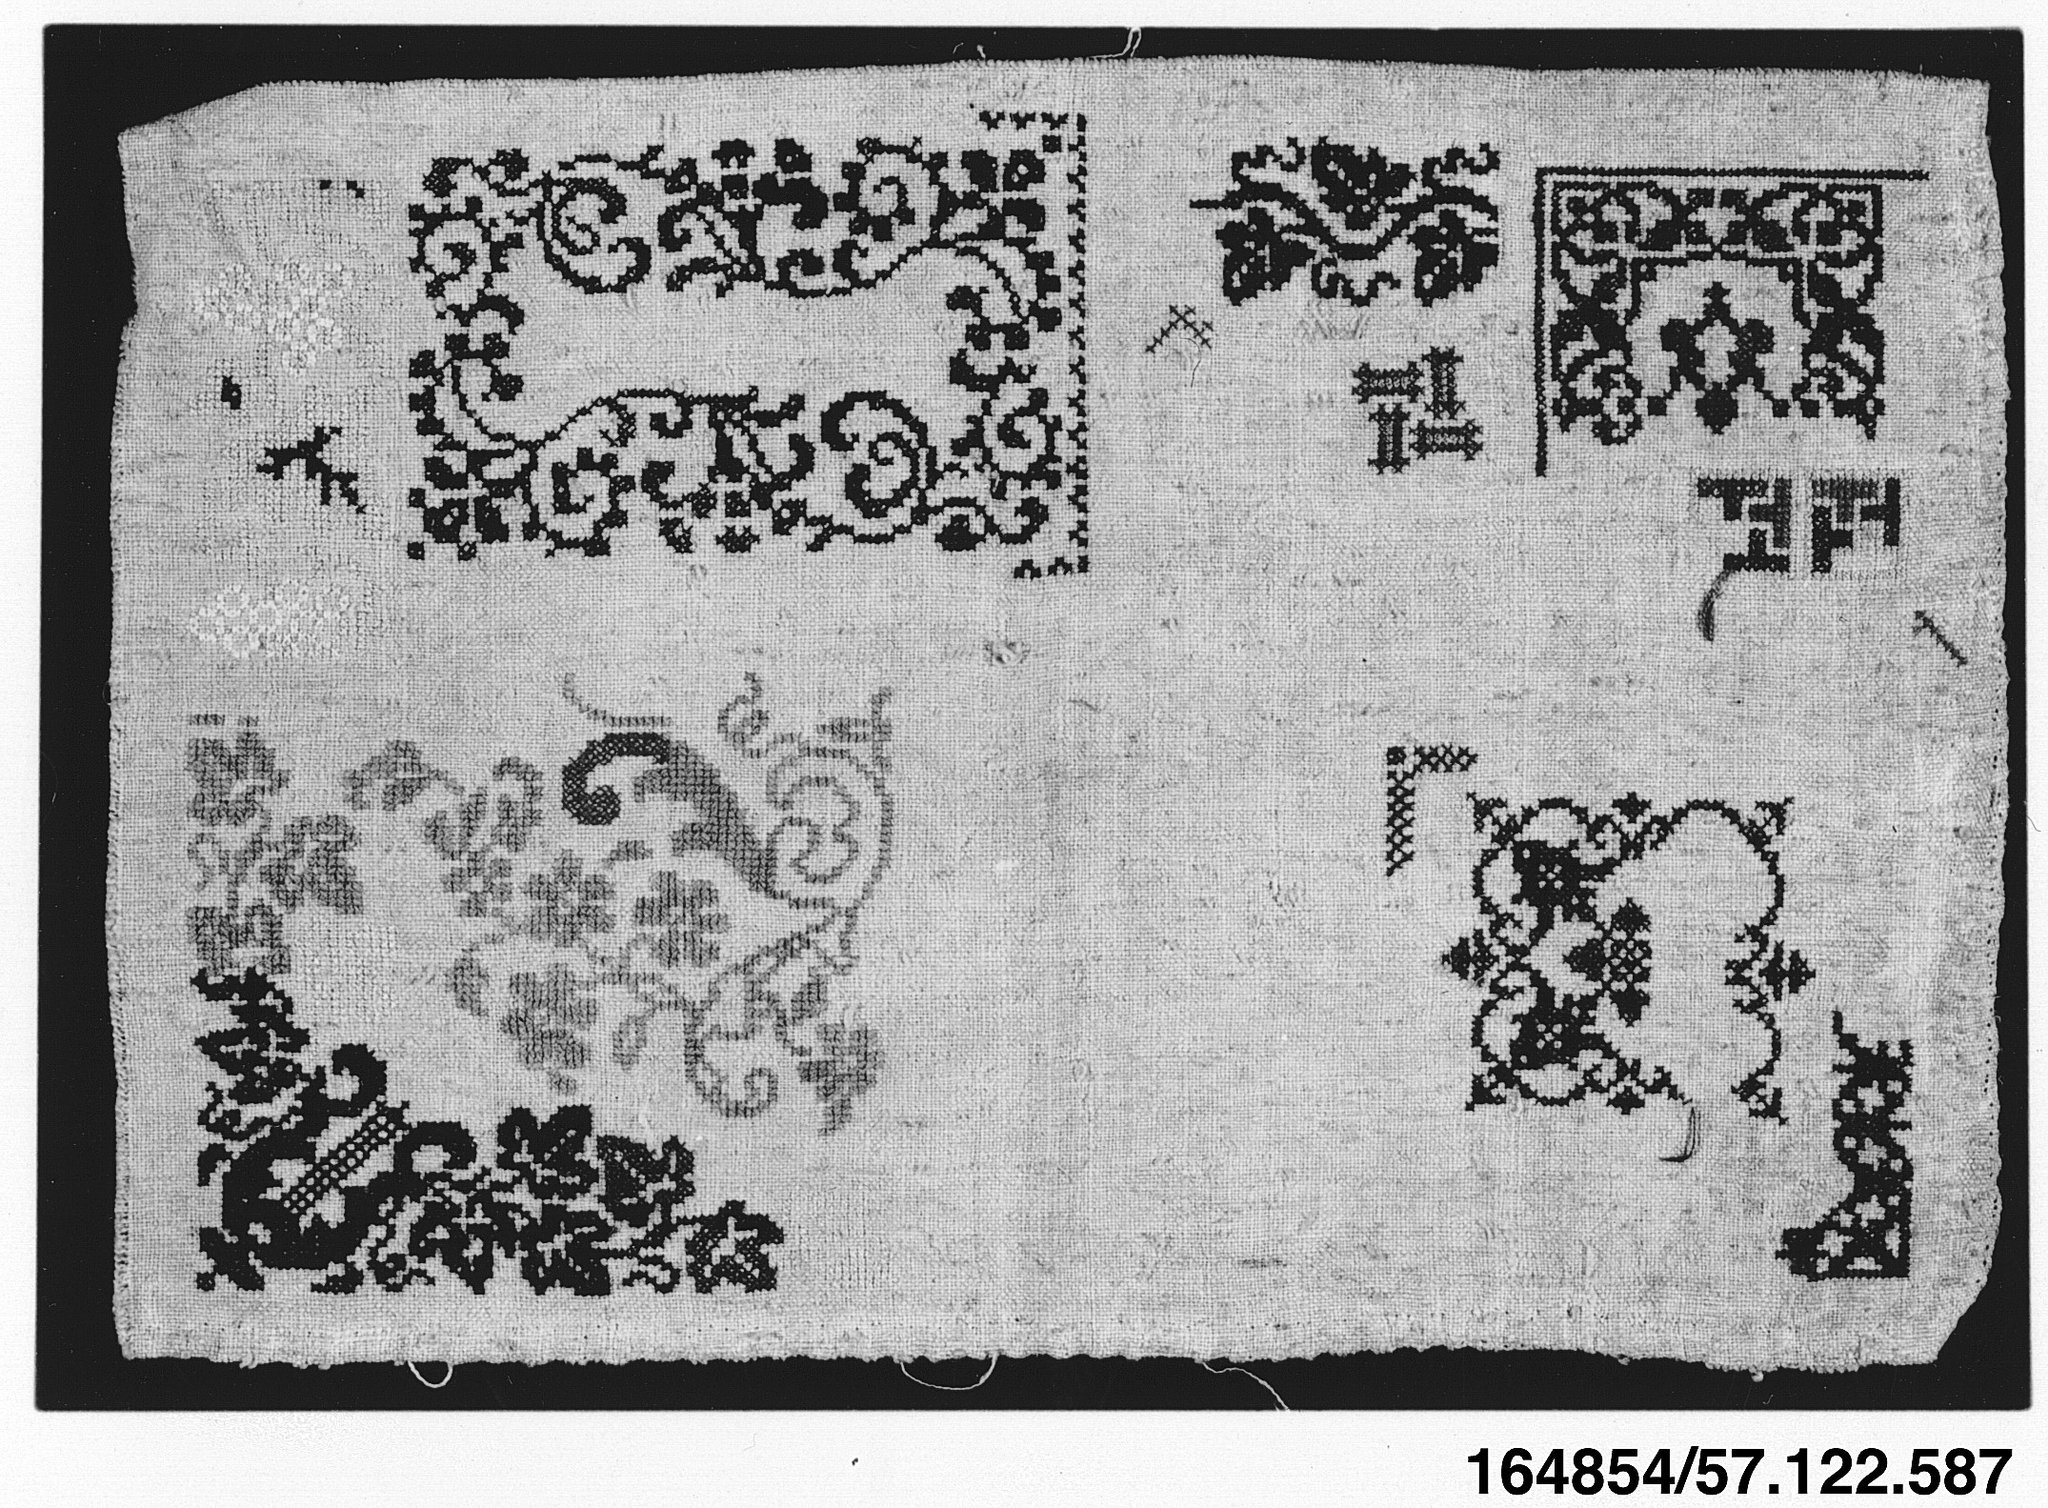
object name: sampler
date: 1801-1900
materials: linen, silk